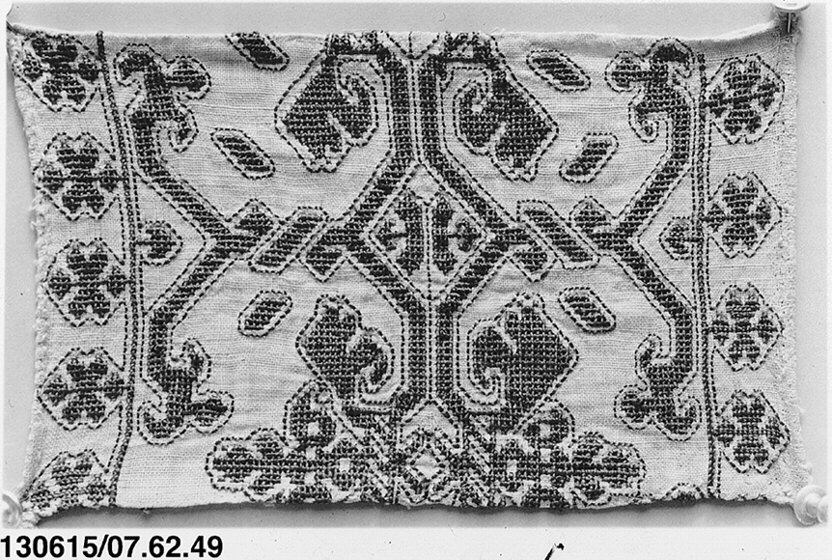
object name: piece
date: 1601-1700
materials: linen, silk